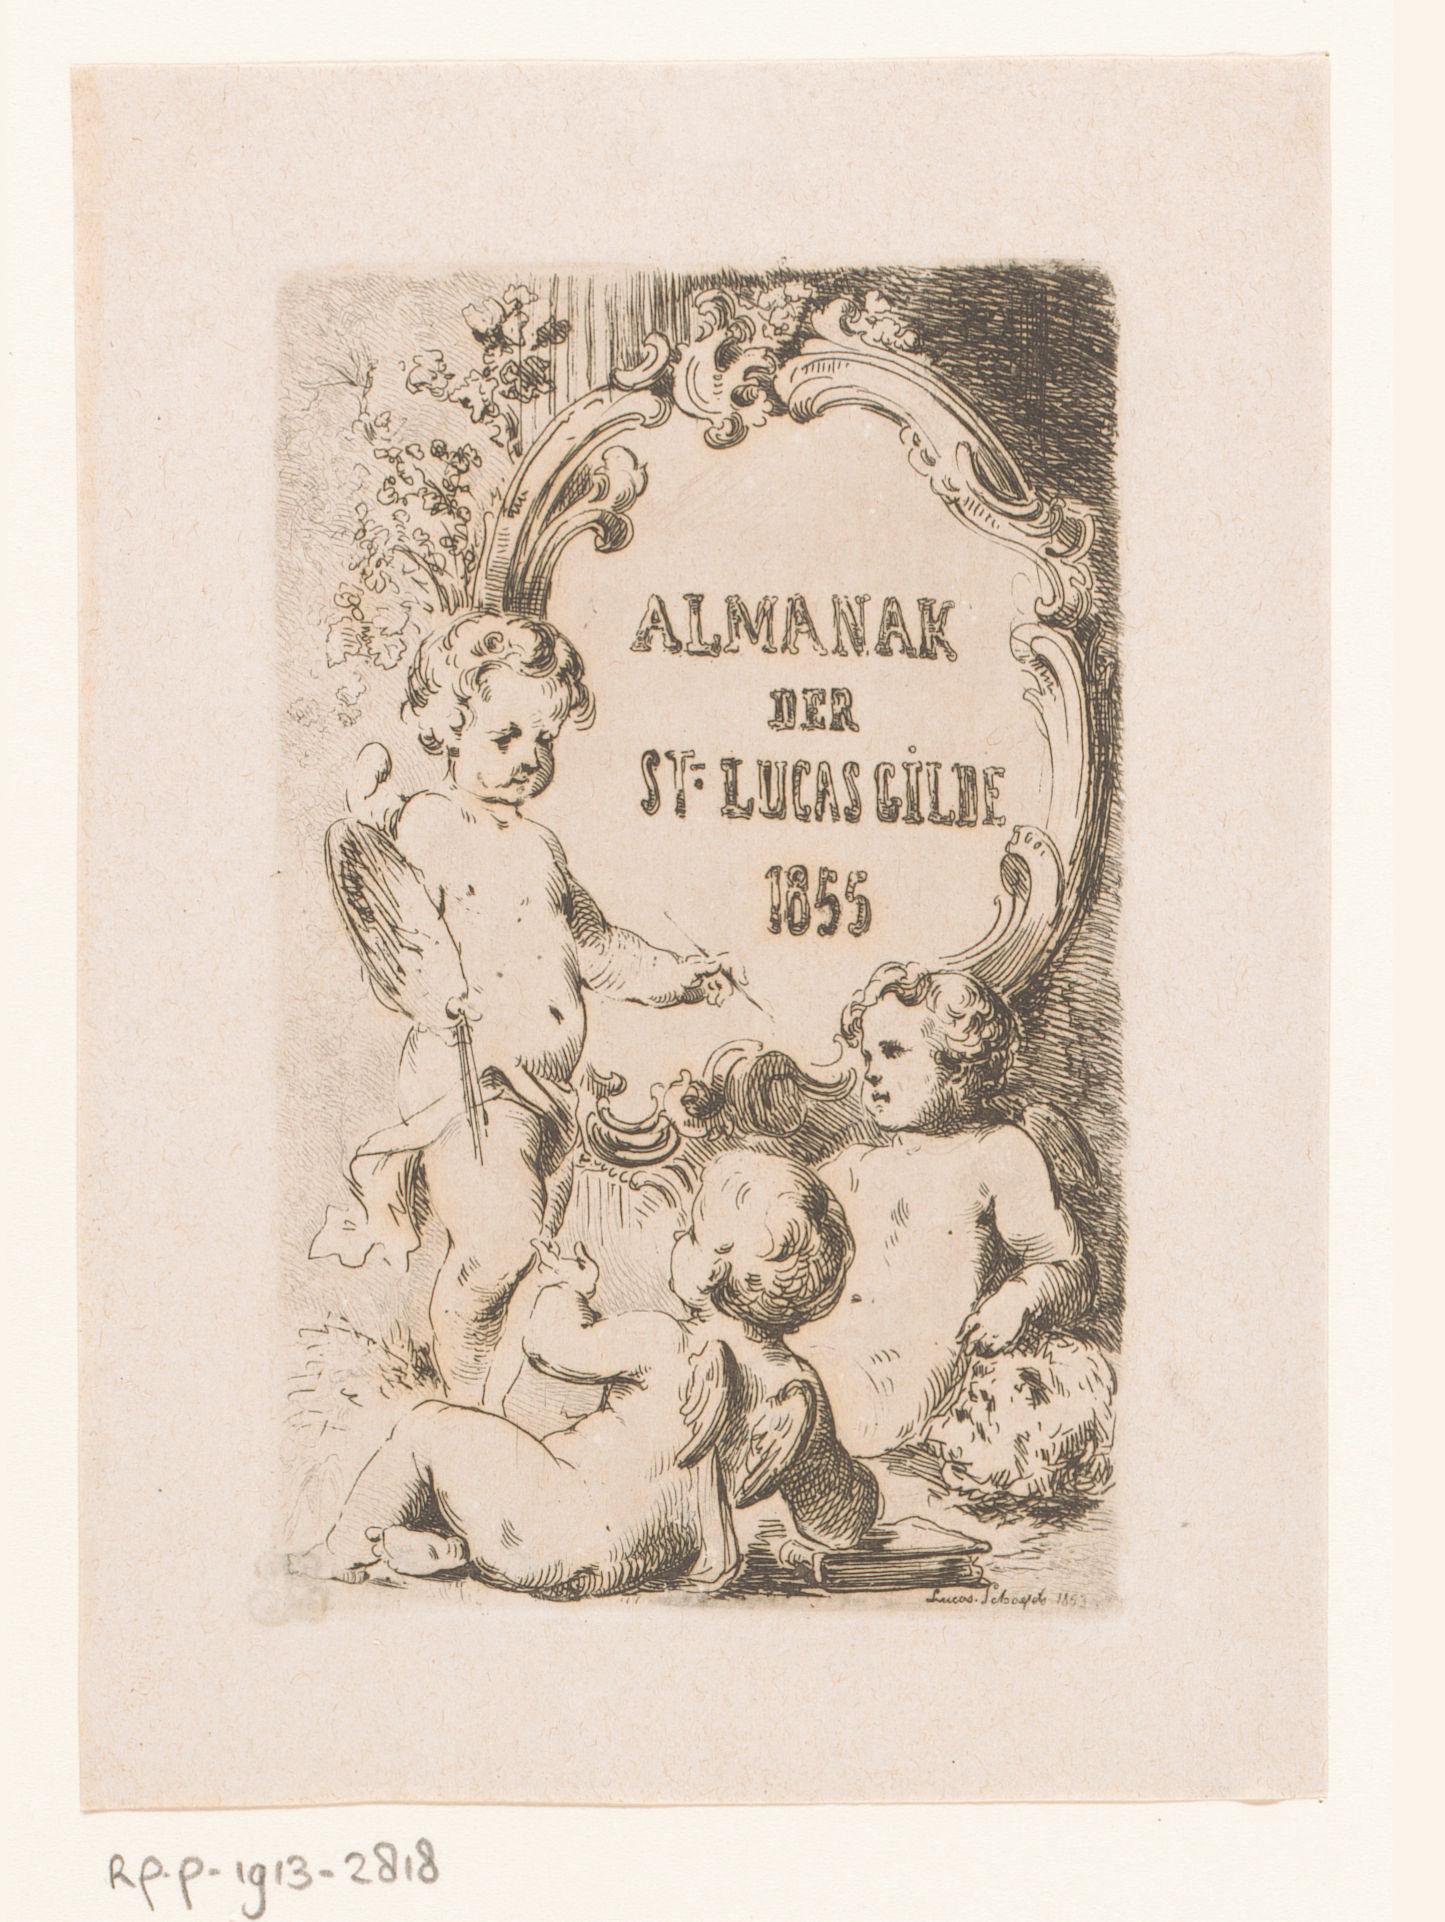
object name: titelblad, titelpagina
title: Drie putti bij een ornamenteel cartouche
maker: lucas victor schaefels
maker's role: draughtsman, print maker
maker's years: 1824-1885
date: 1853-1855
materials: paper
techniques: aquatint, etching, intaglio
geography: antwerp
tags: 'pictura', symbolic representations, allegories and emblems ~ painting; 'pittura' (ripa), 'sculptura', symbolic representations, allegories and emblems ~ sculpture; 'scoltura' (ripa), 'architectura', symbolic representations, allegories and emblems ~ architecture; 'architettura' (ripa), cupids: 'amores', 'amoretti', 'putti'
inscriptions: collector's mark: Lugt 1485, collector's mark: Lugt 2228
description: Titelpagina voor: Almanak der St.-Lukas Gilde voor het jaar 1854 & 1855. Antwerpen: Gebroeders Peeters, 1855.